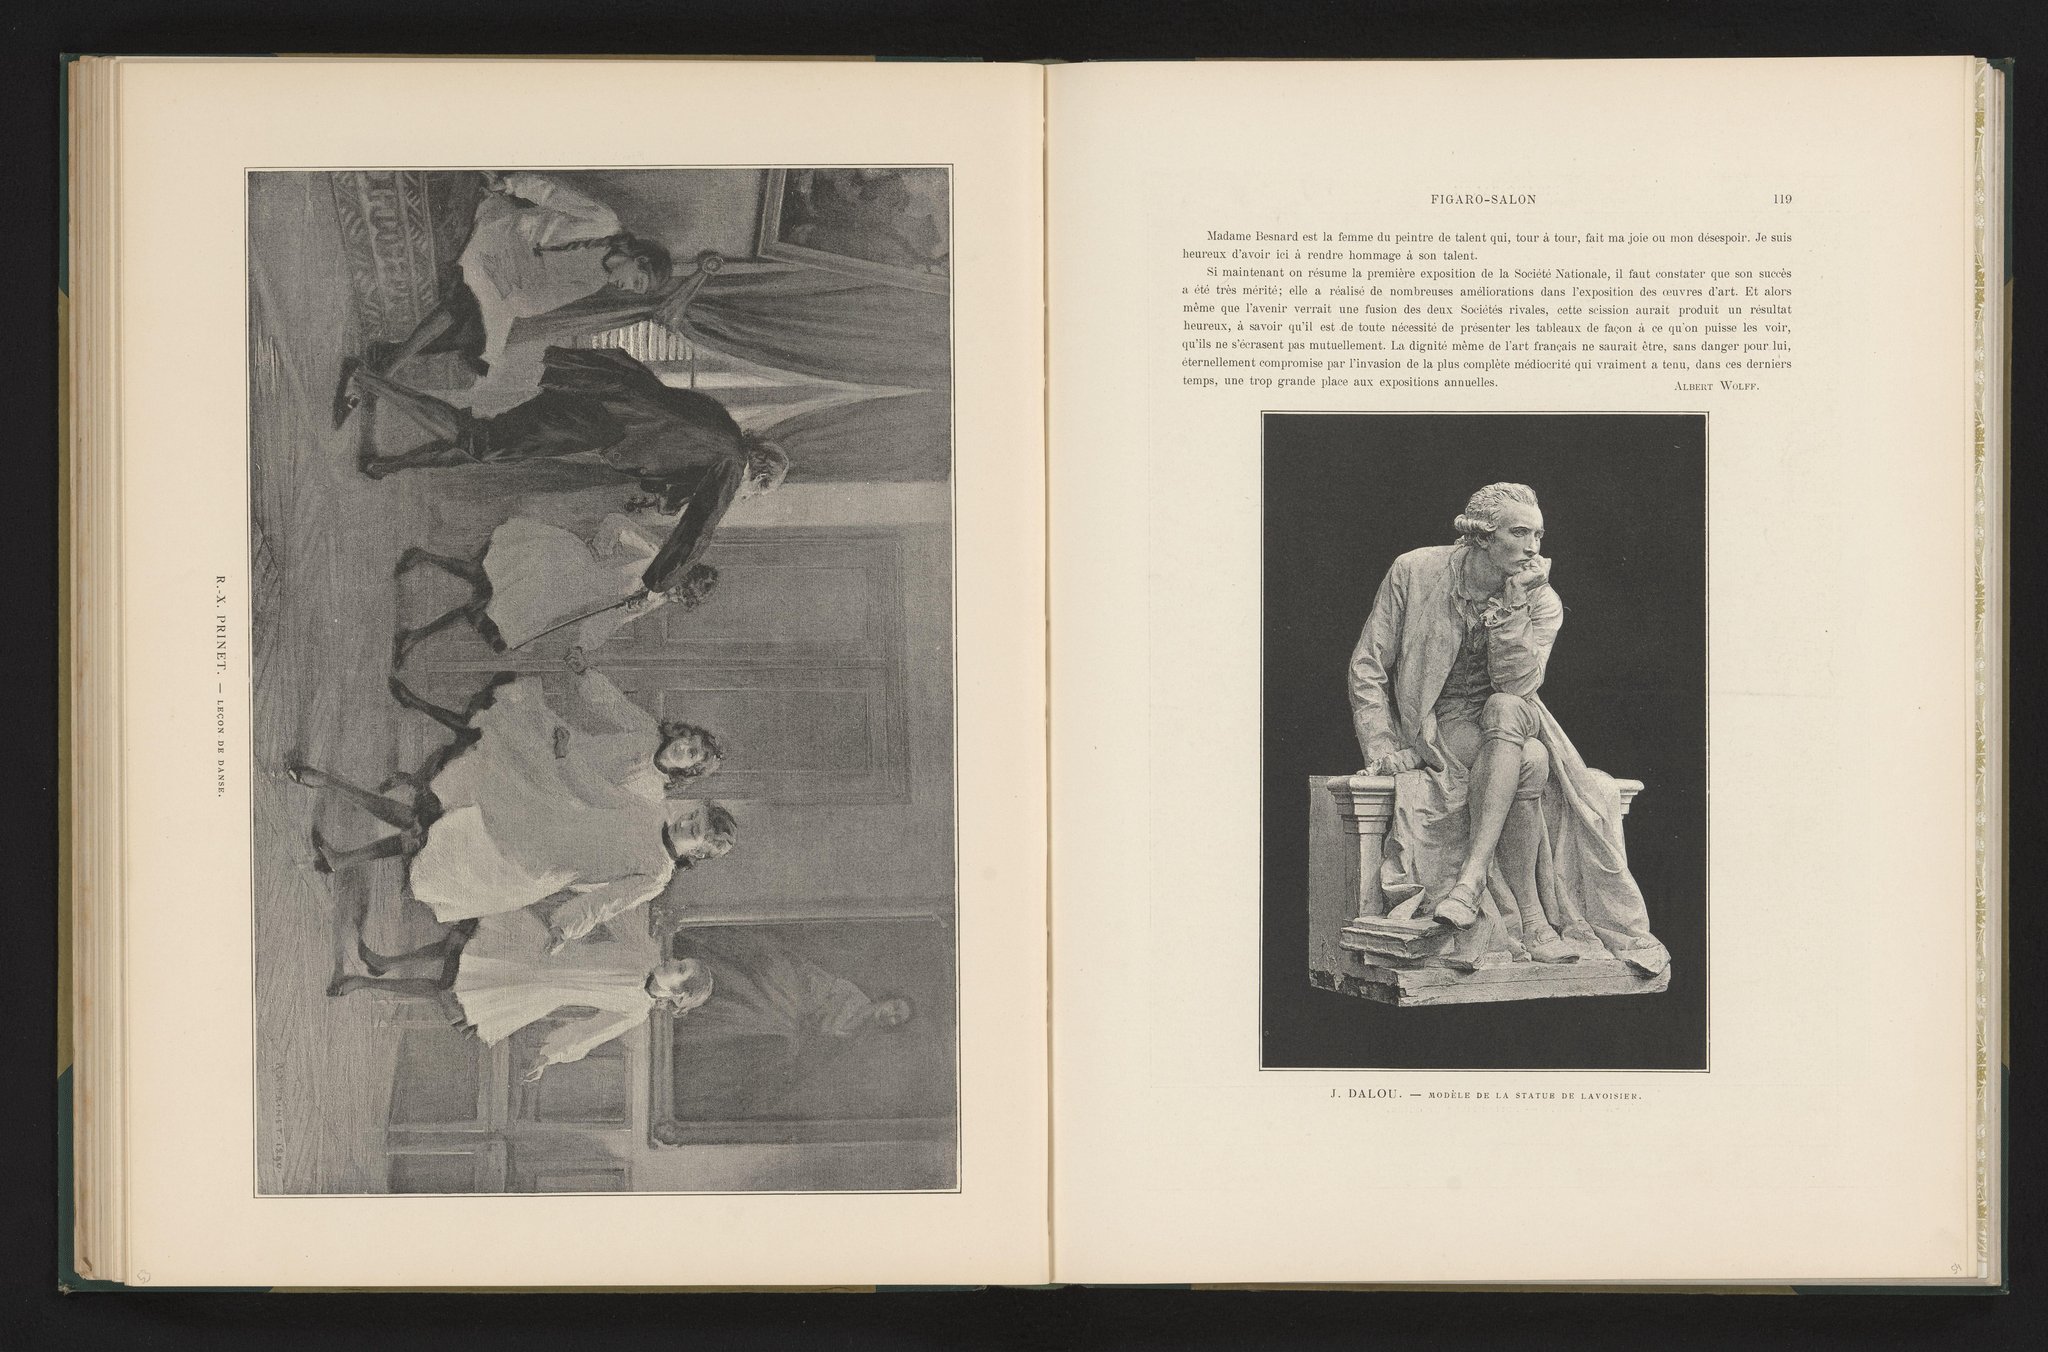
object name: page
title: Leçon de danse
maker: Anonymous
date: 1885-1901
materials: paper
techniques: autotype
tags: teacher and pupil, group dancing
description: Prent op pagina 118 van Figaro-Salon (par Albert Wolff).